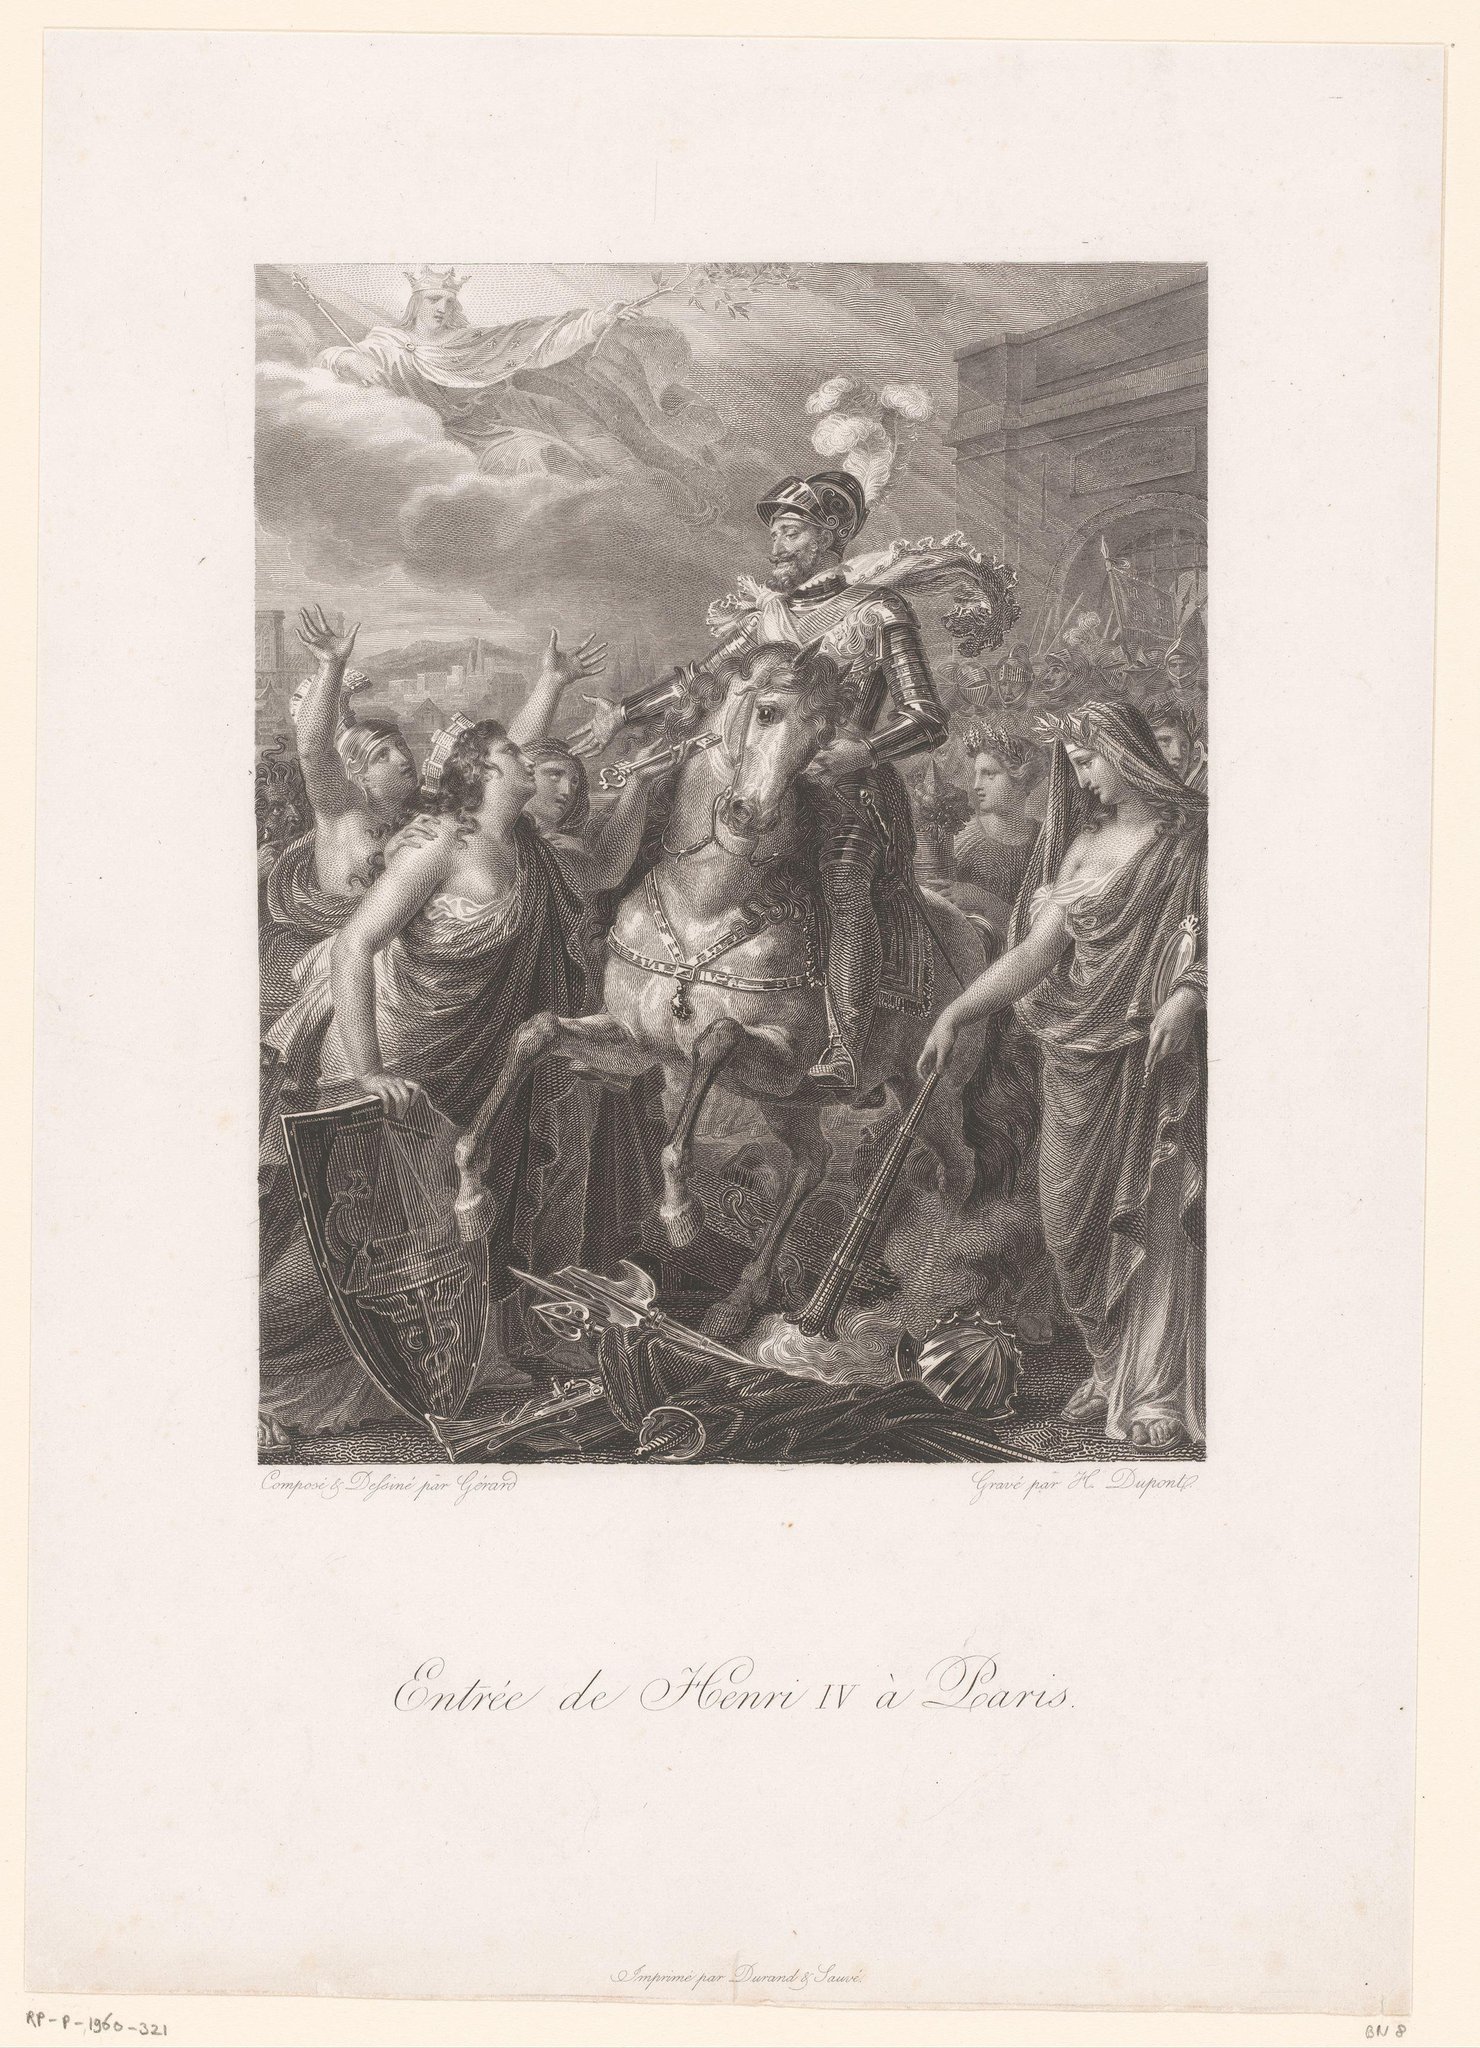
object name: print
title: Ontvangst van koning Hendrik IV te Parijs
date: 1819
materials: paper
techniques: etching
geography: paris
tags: hendrik iv (koning van frankrijk en navarra), historical persons, king, paris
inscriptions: collector's mark: Lugt 2228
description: Volgens IFF après 1800, p. 283 betreft dit een titelpagina voor een uitgave van de 'Henriade', uitgegeven door Didot.